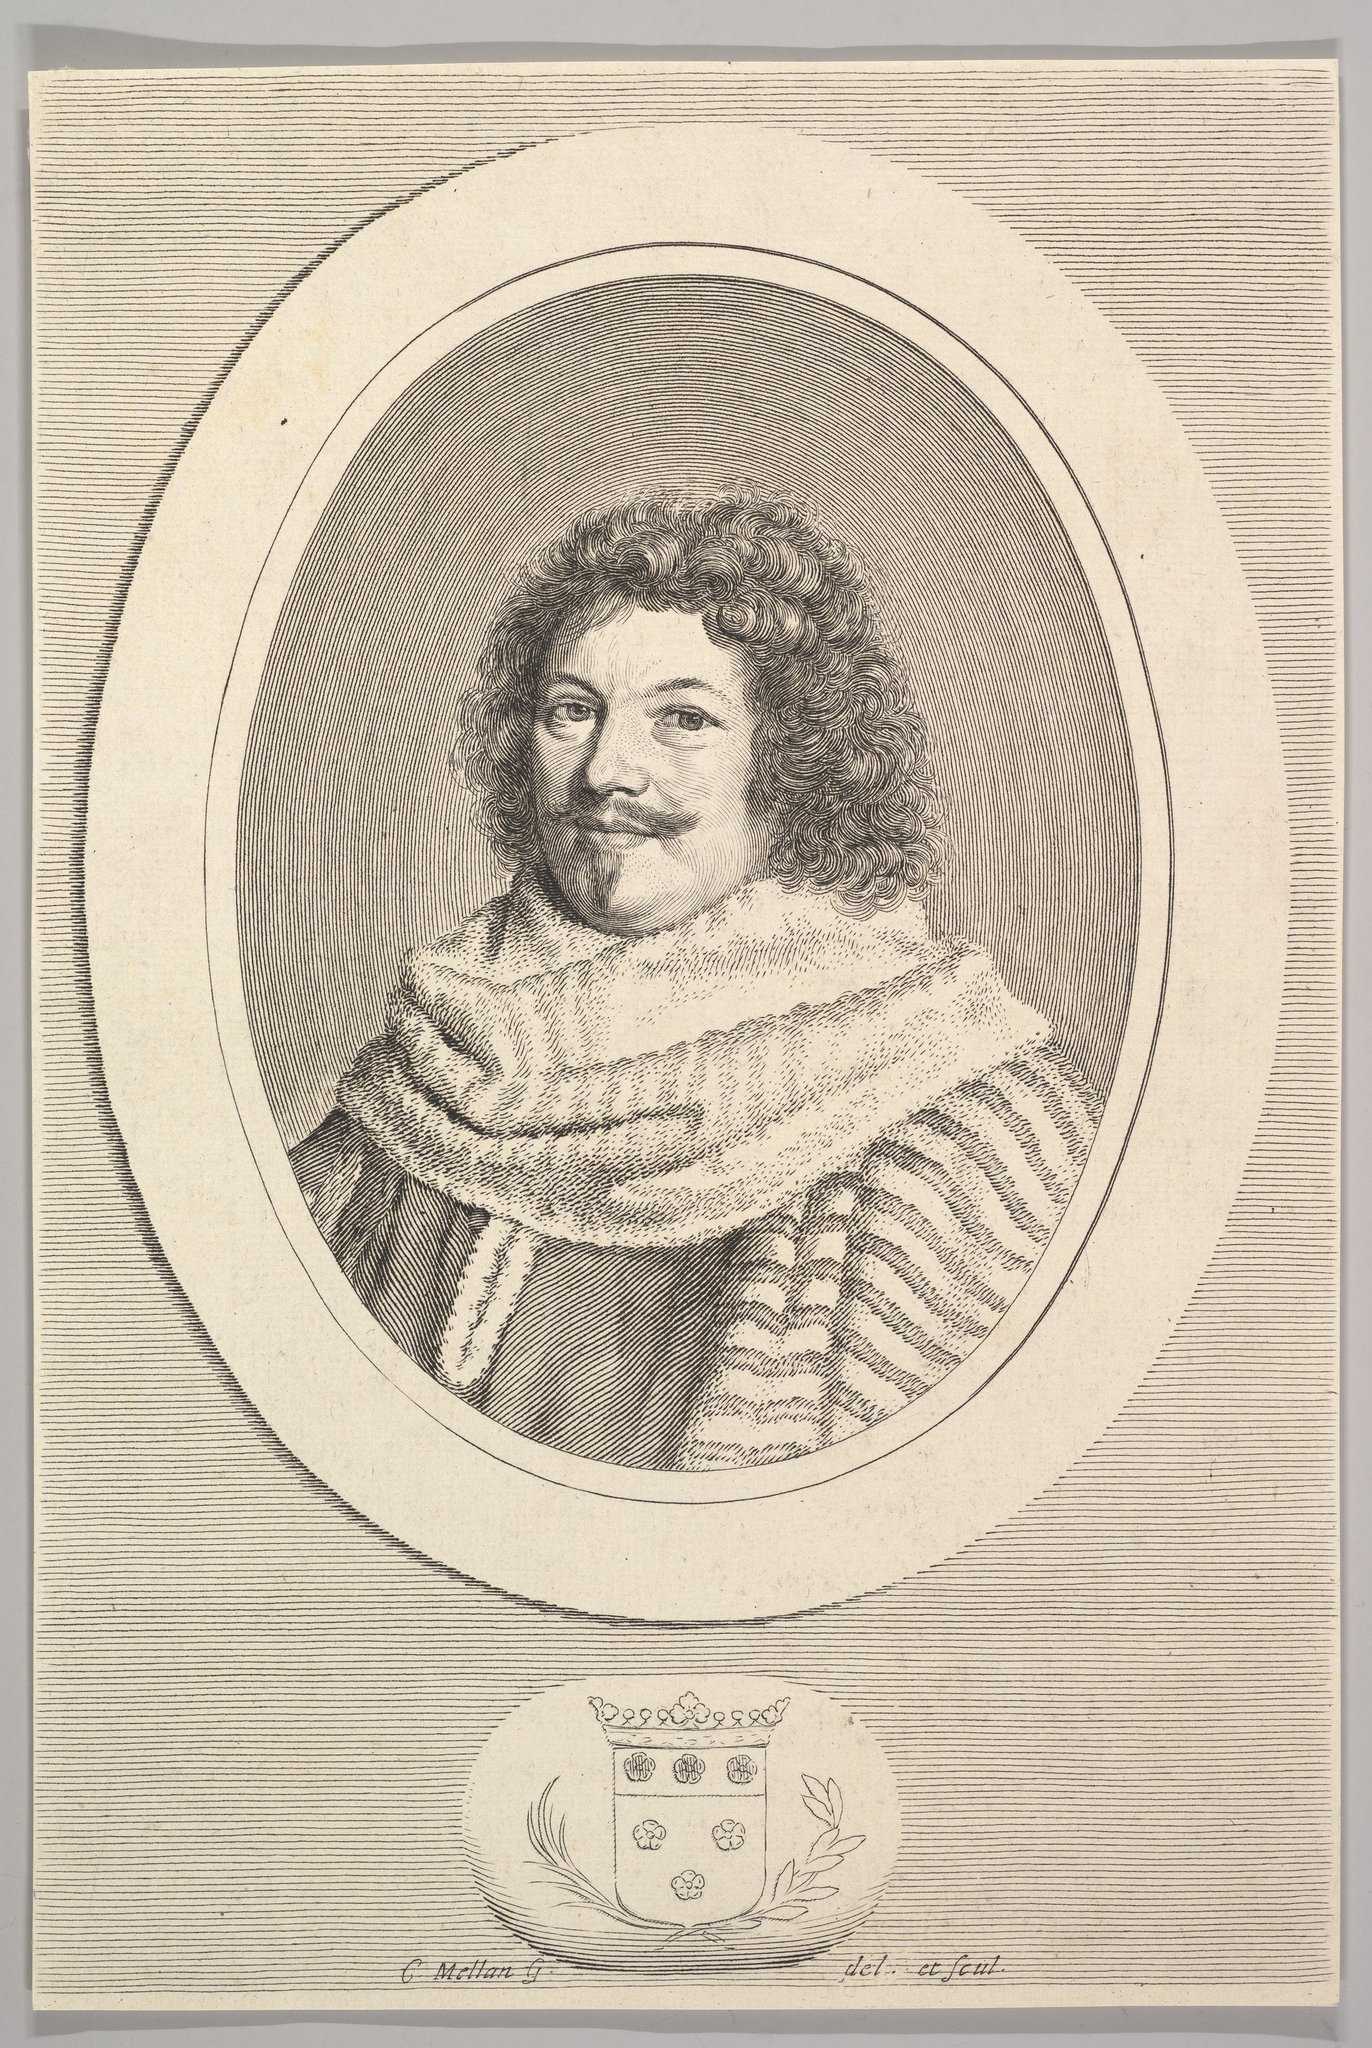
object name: print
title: René de Longueil, marquis de Maisons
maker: claude mellan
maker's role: artist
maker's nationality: french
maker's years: 1598-1688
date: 1600-1677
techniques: engraving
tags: men,portraits